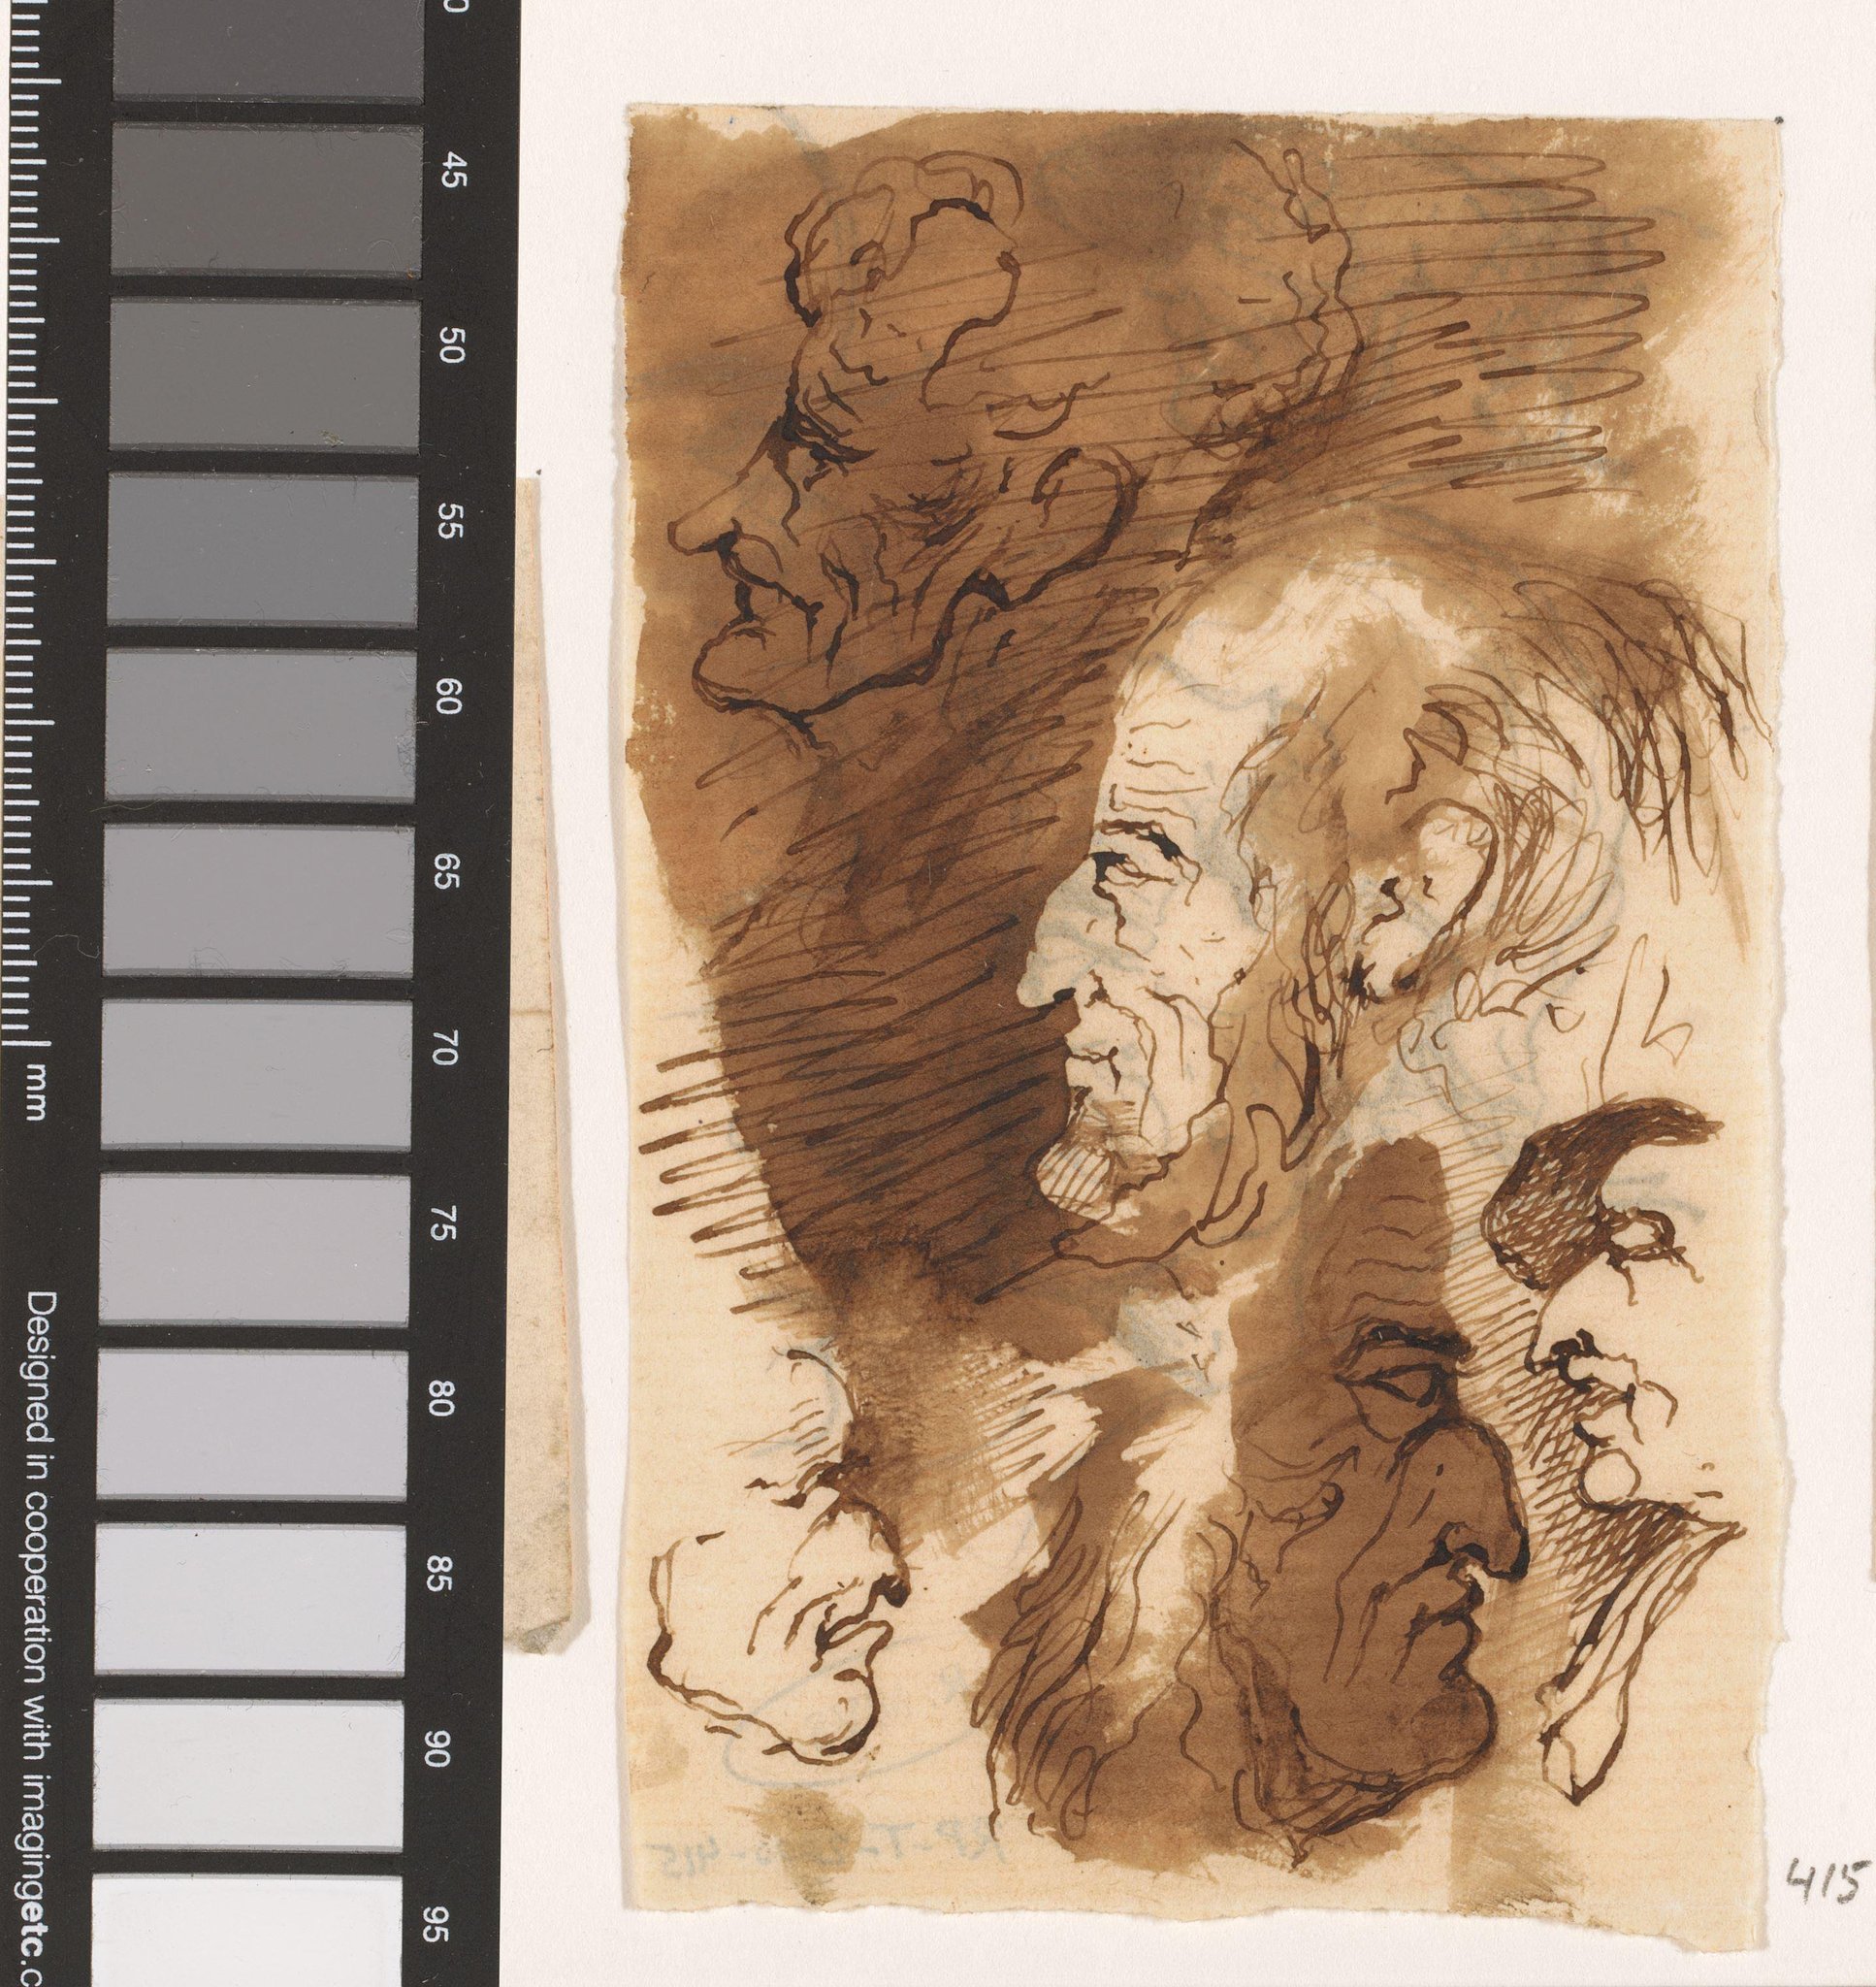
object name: drawing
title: Koppen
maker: johannes tavenraat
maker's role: draughtsman, painter, print maker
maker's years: 1809-1881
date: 1840-1880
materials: ink, paper, pencil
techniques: brush, pen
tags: caricatures (human types)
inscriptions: collector's mark: Lugt 2228